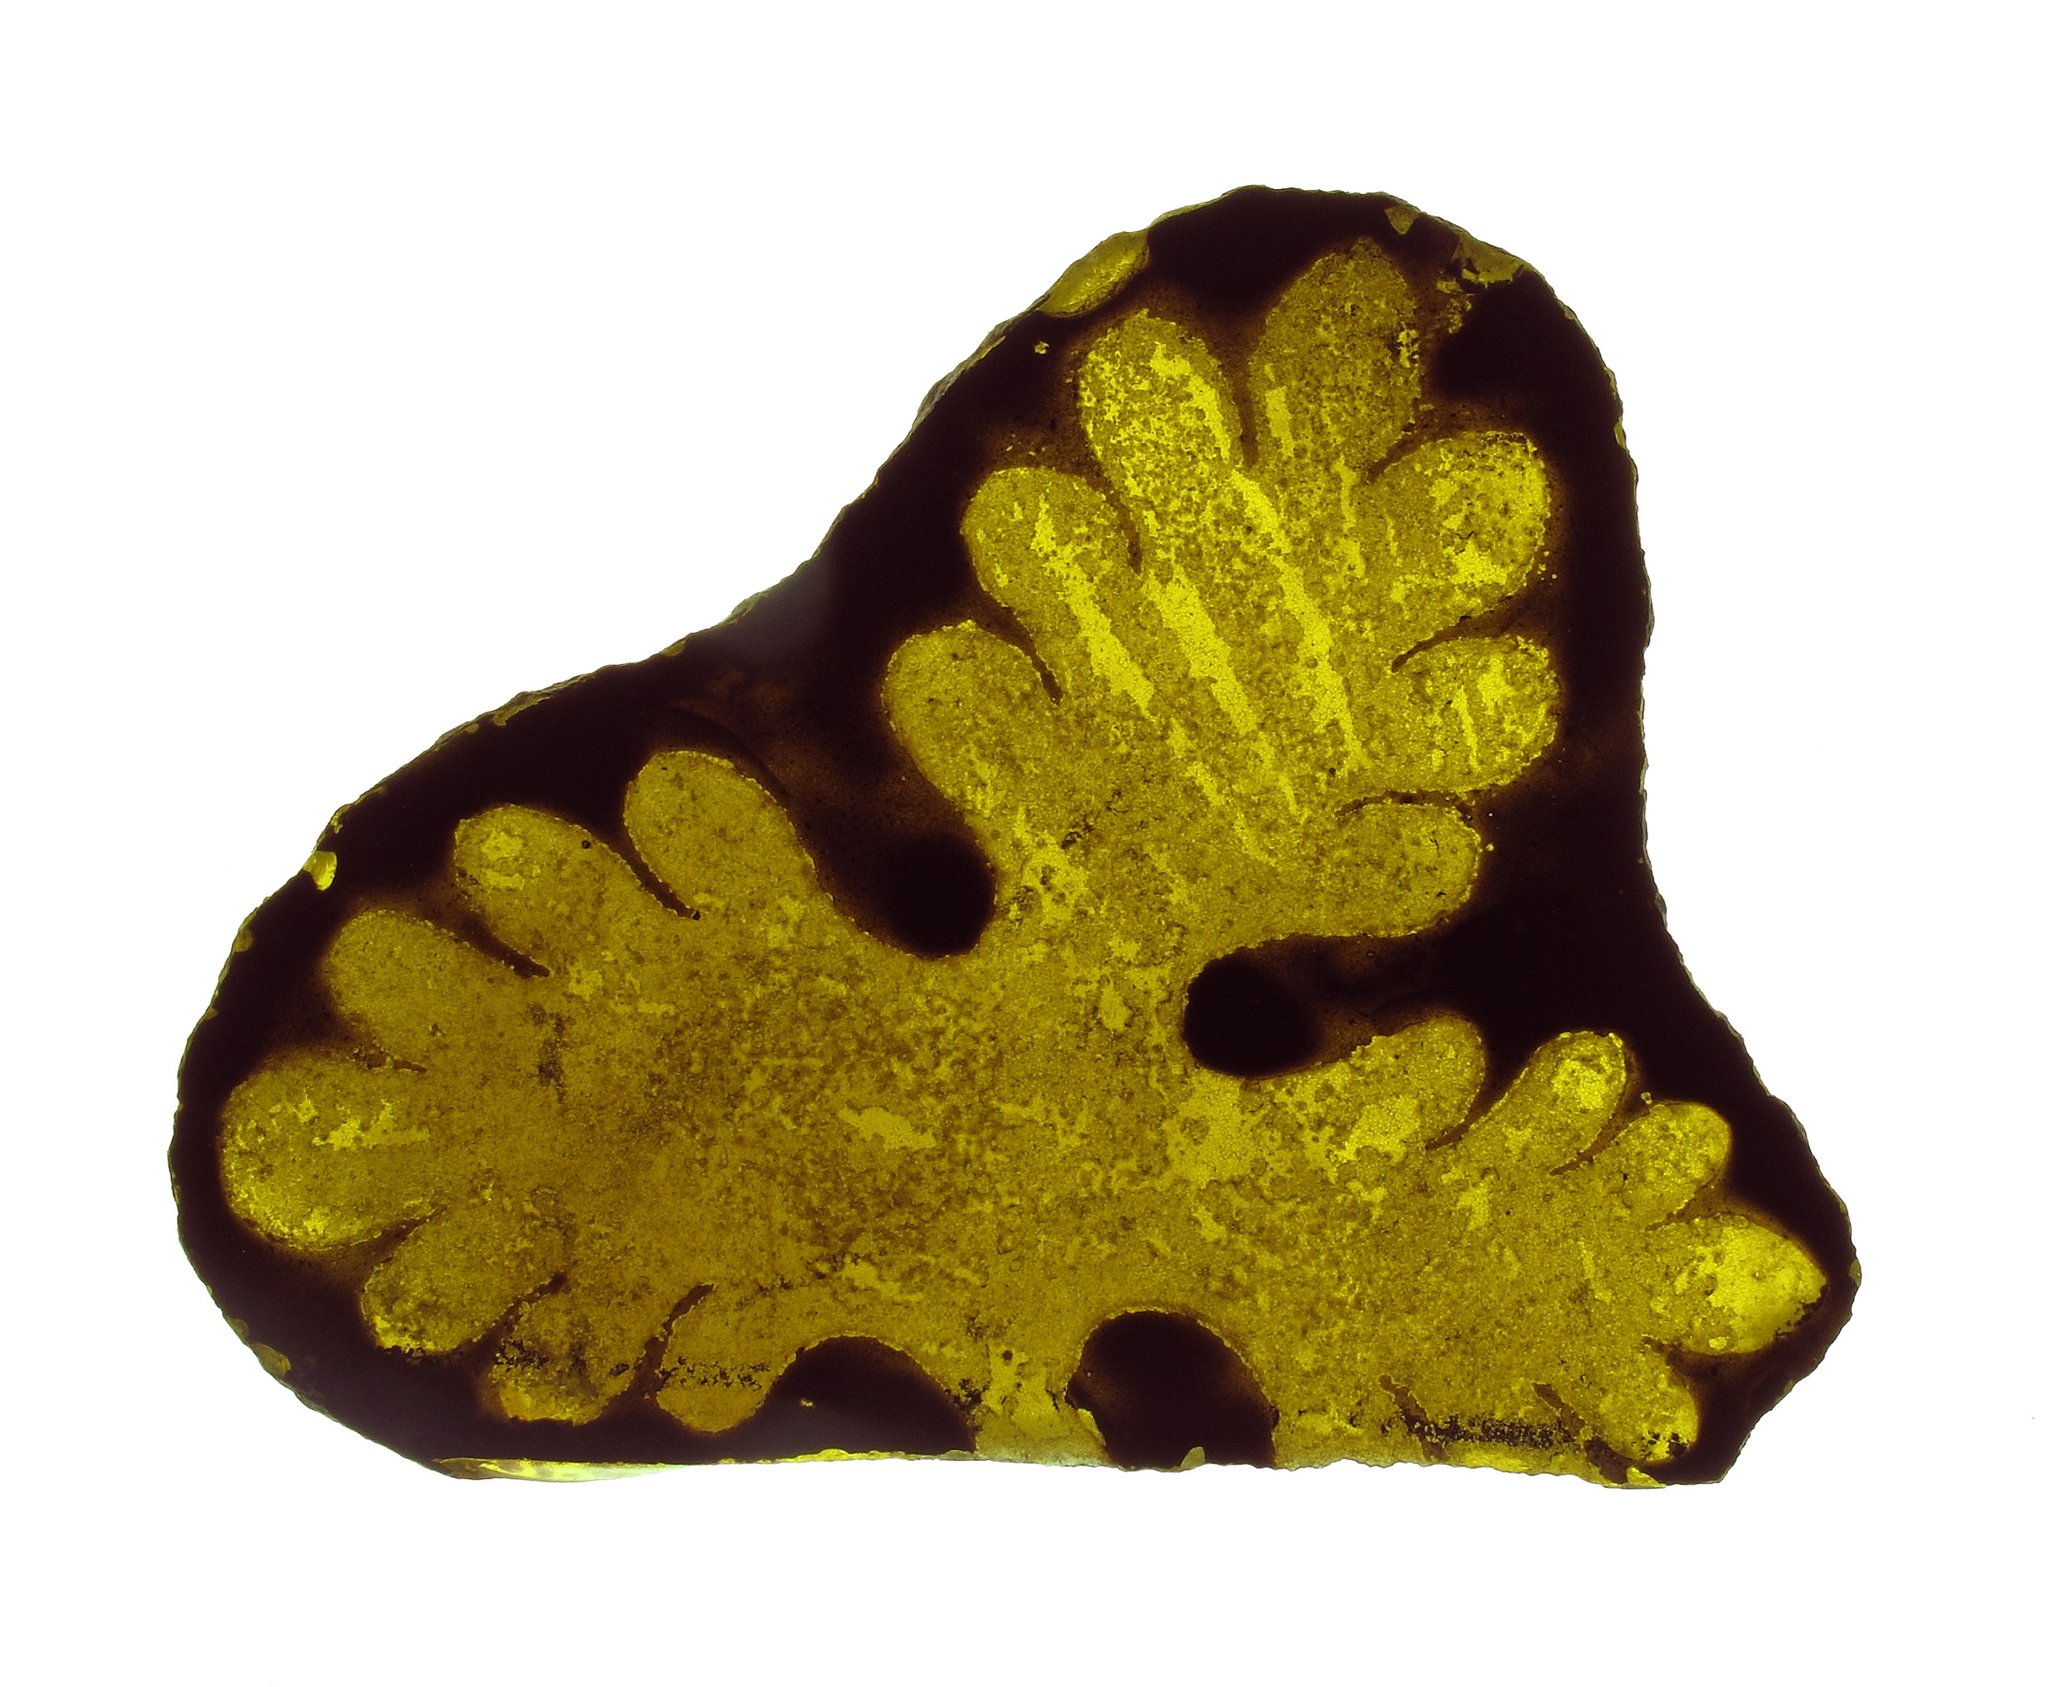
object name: fragment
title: Glass Fragment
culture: european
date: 1401-1500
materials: glass, metal